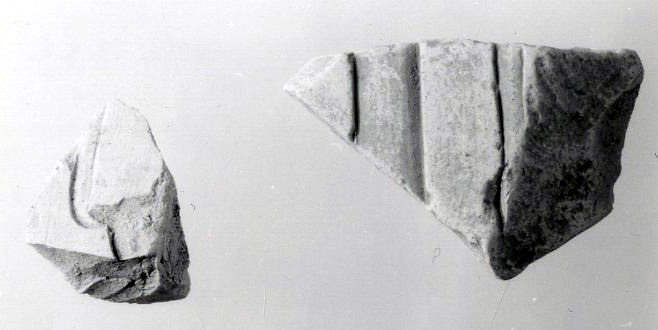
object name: relief fragment, tomb of meketre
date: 1981-1975 BCE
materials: limestone, paint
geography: egypt